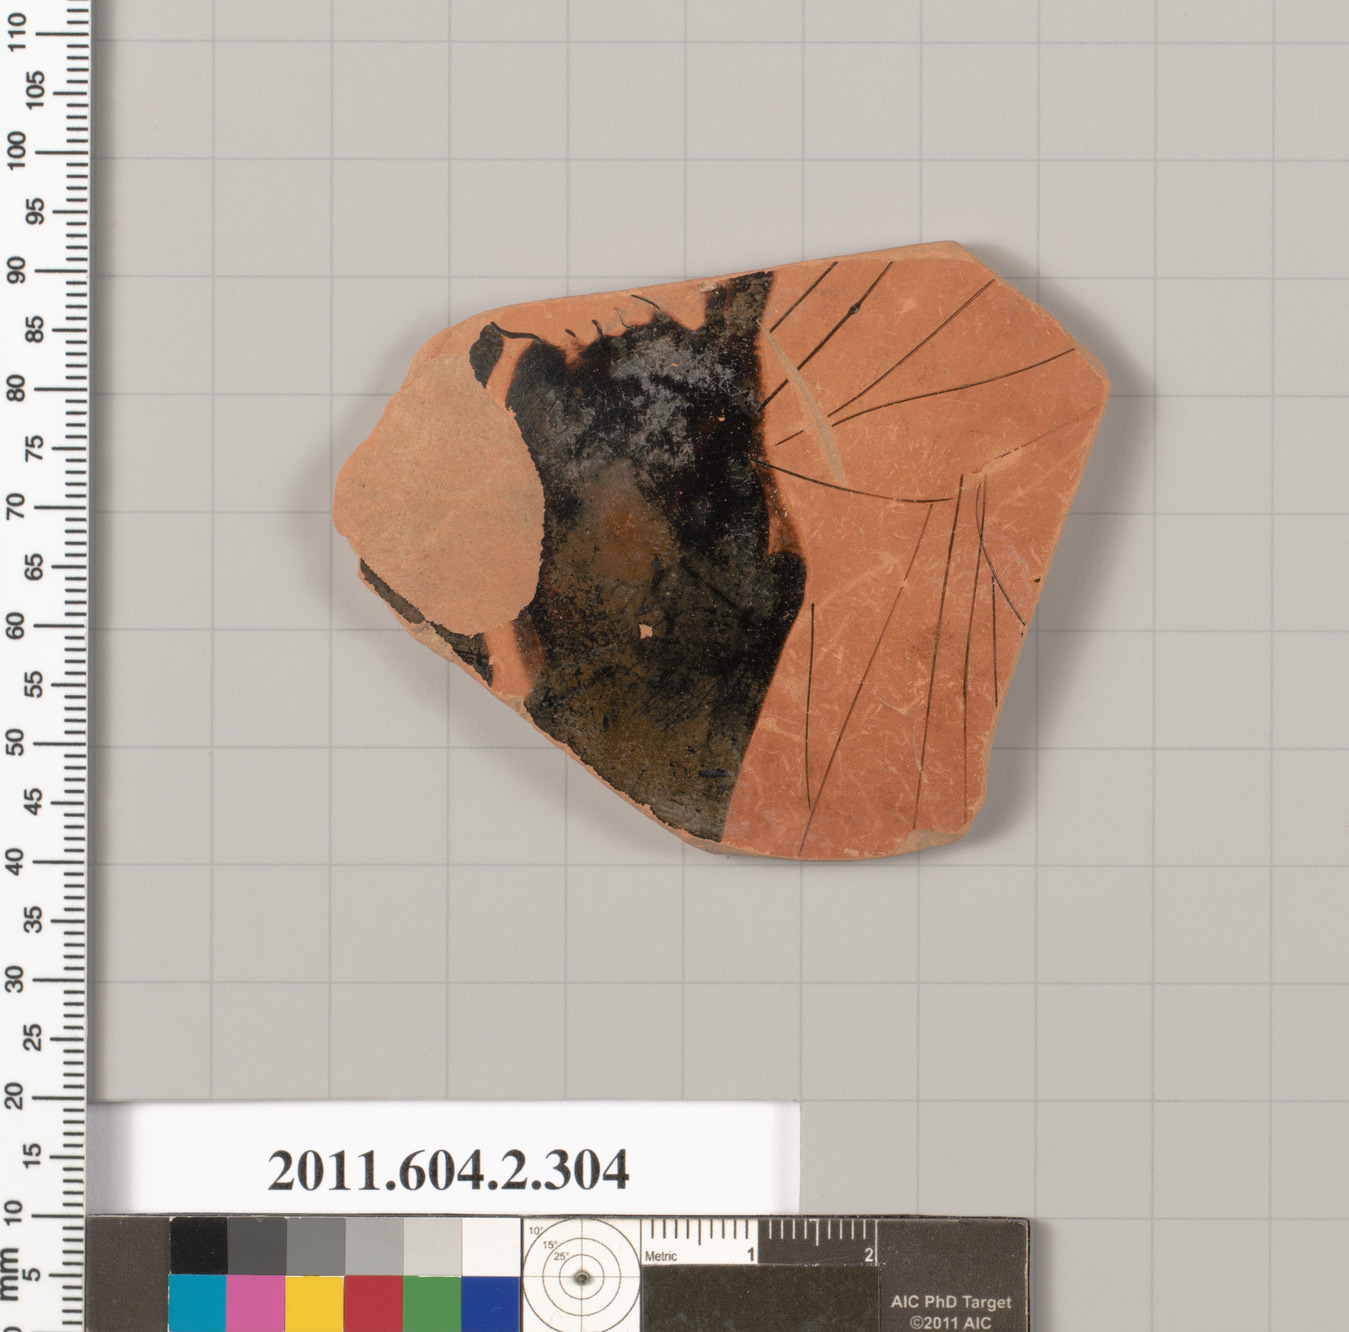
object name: column krater fragment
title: Terracotta fragment of a column-krater (bowl for mixing wine and water)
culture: greek, attic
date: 467-435 BCE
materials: terracotta